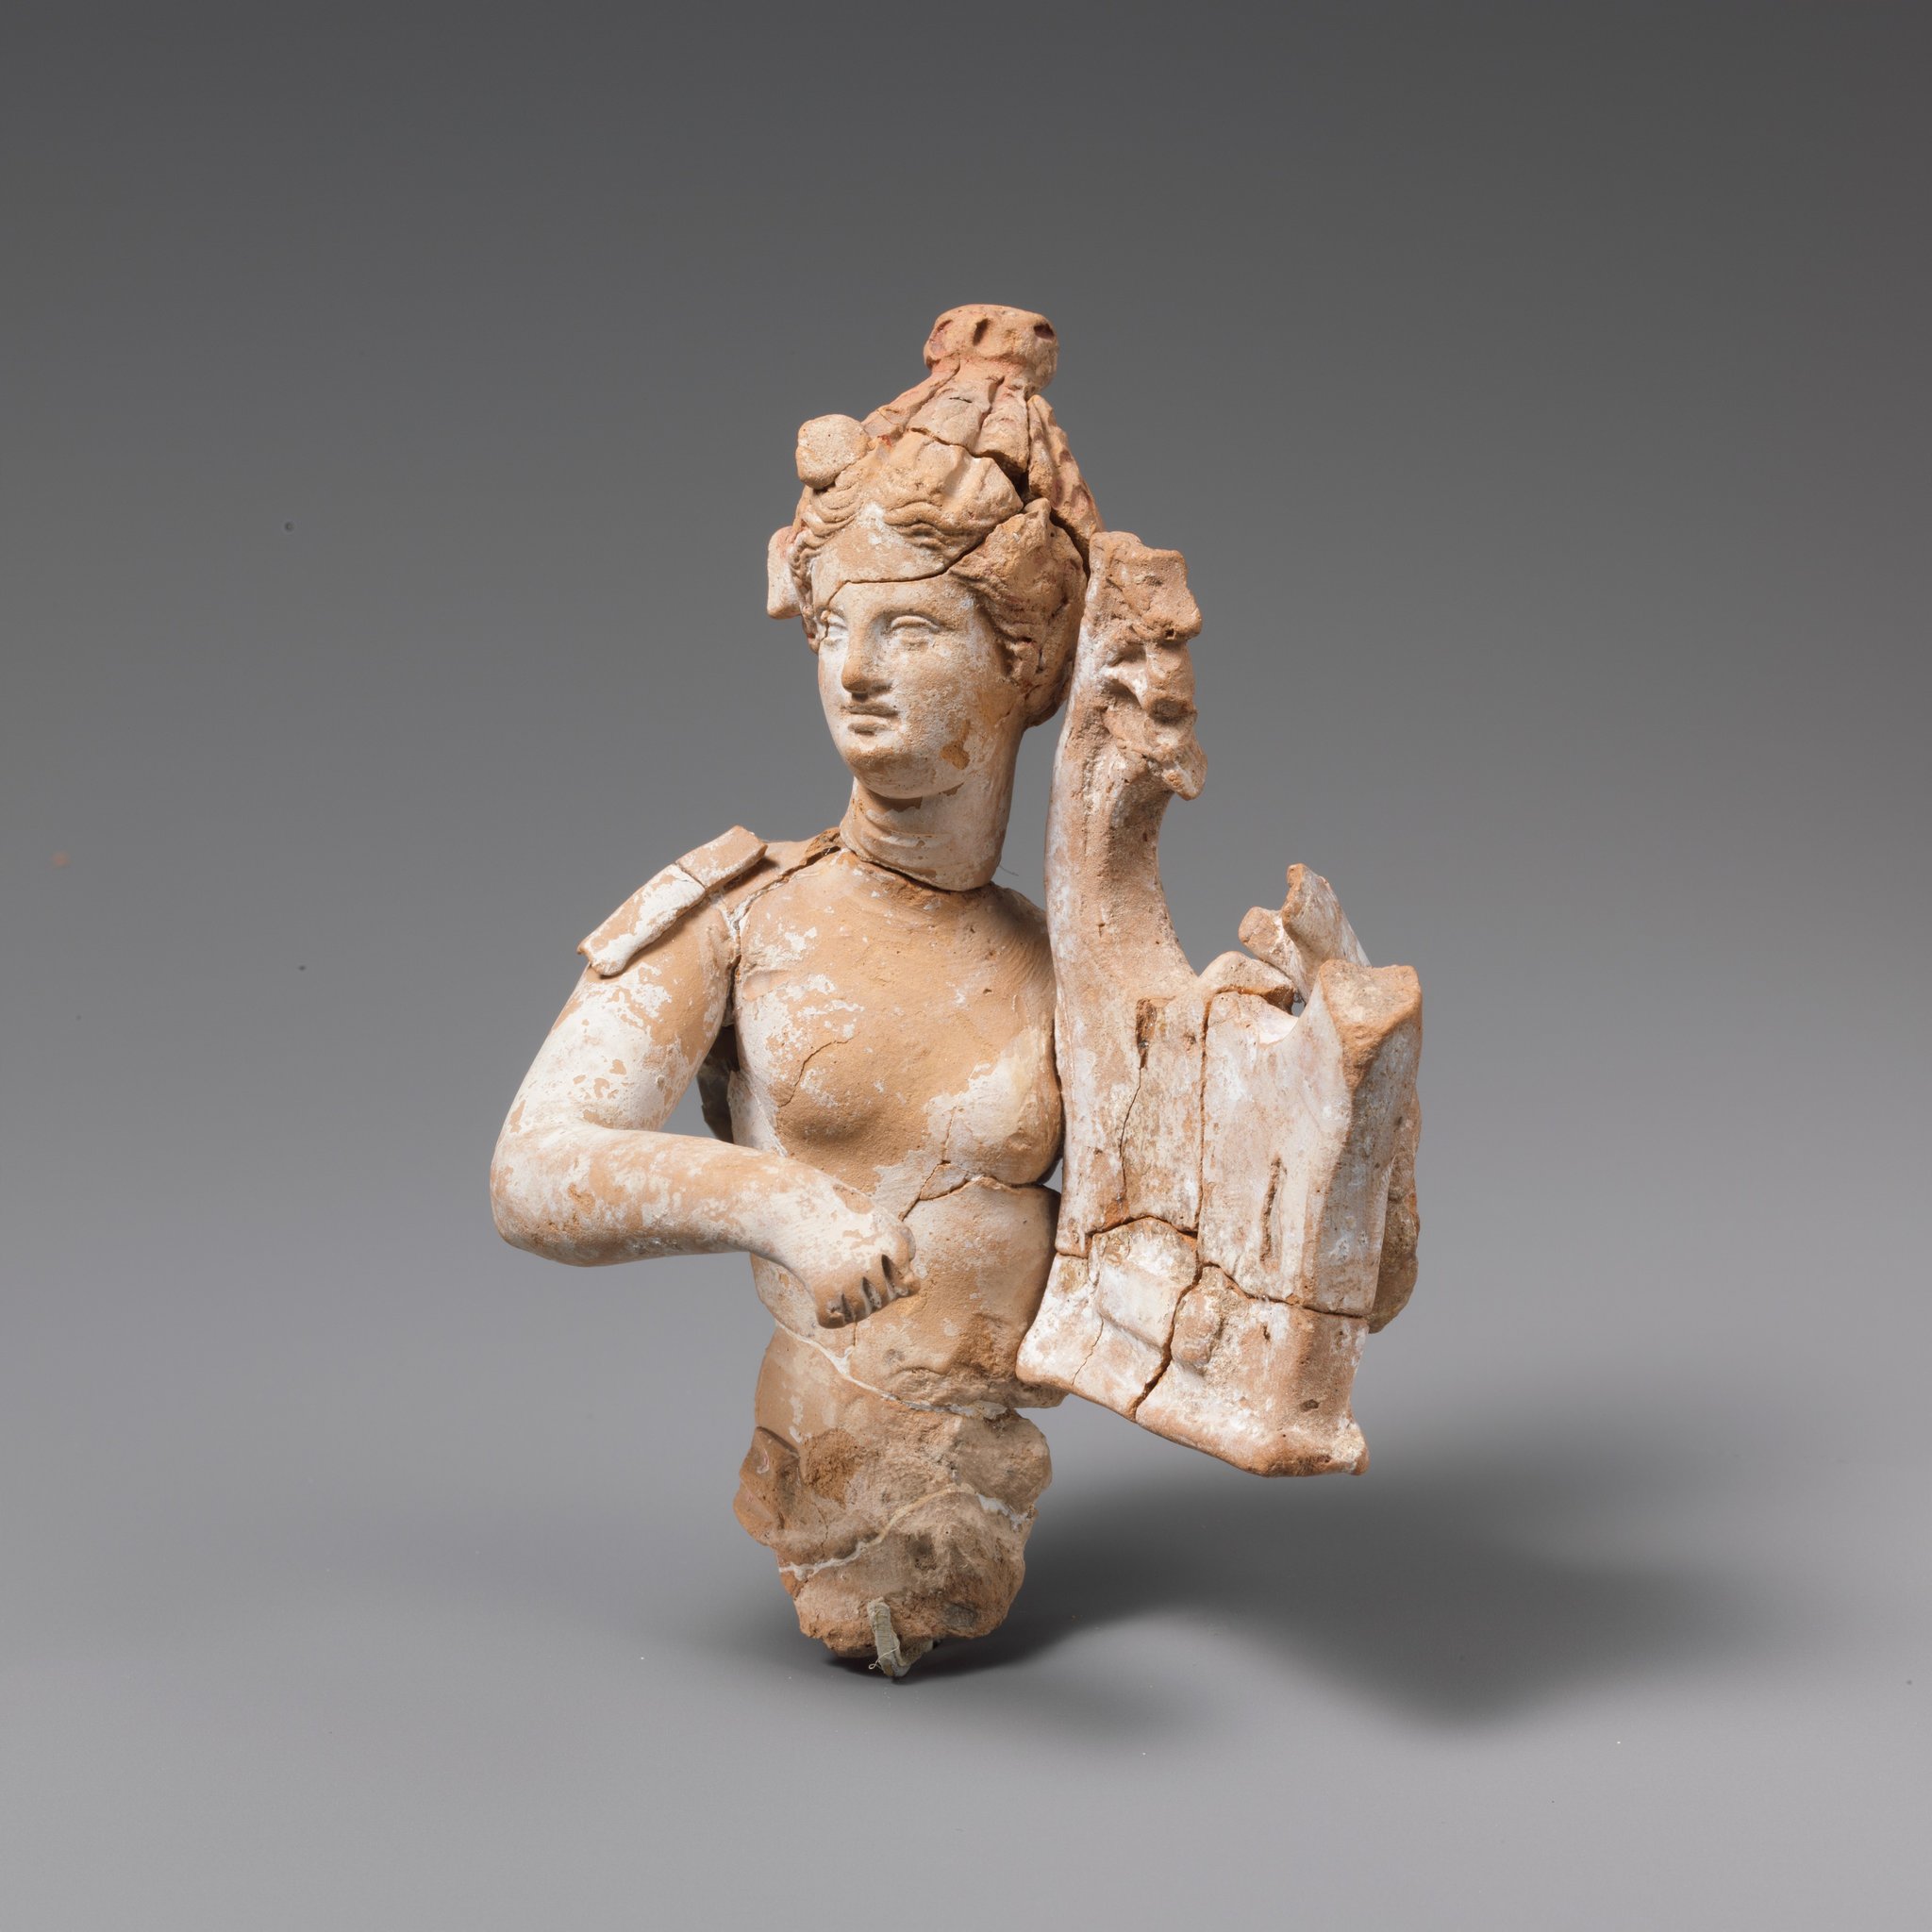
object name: bust of a woman with kithara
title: Fragmentary terracotta statuette of a woman with a kithara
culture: greek, south italian, tarentine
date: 300-201 BCE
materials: terracotta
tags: musical instruments,women